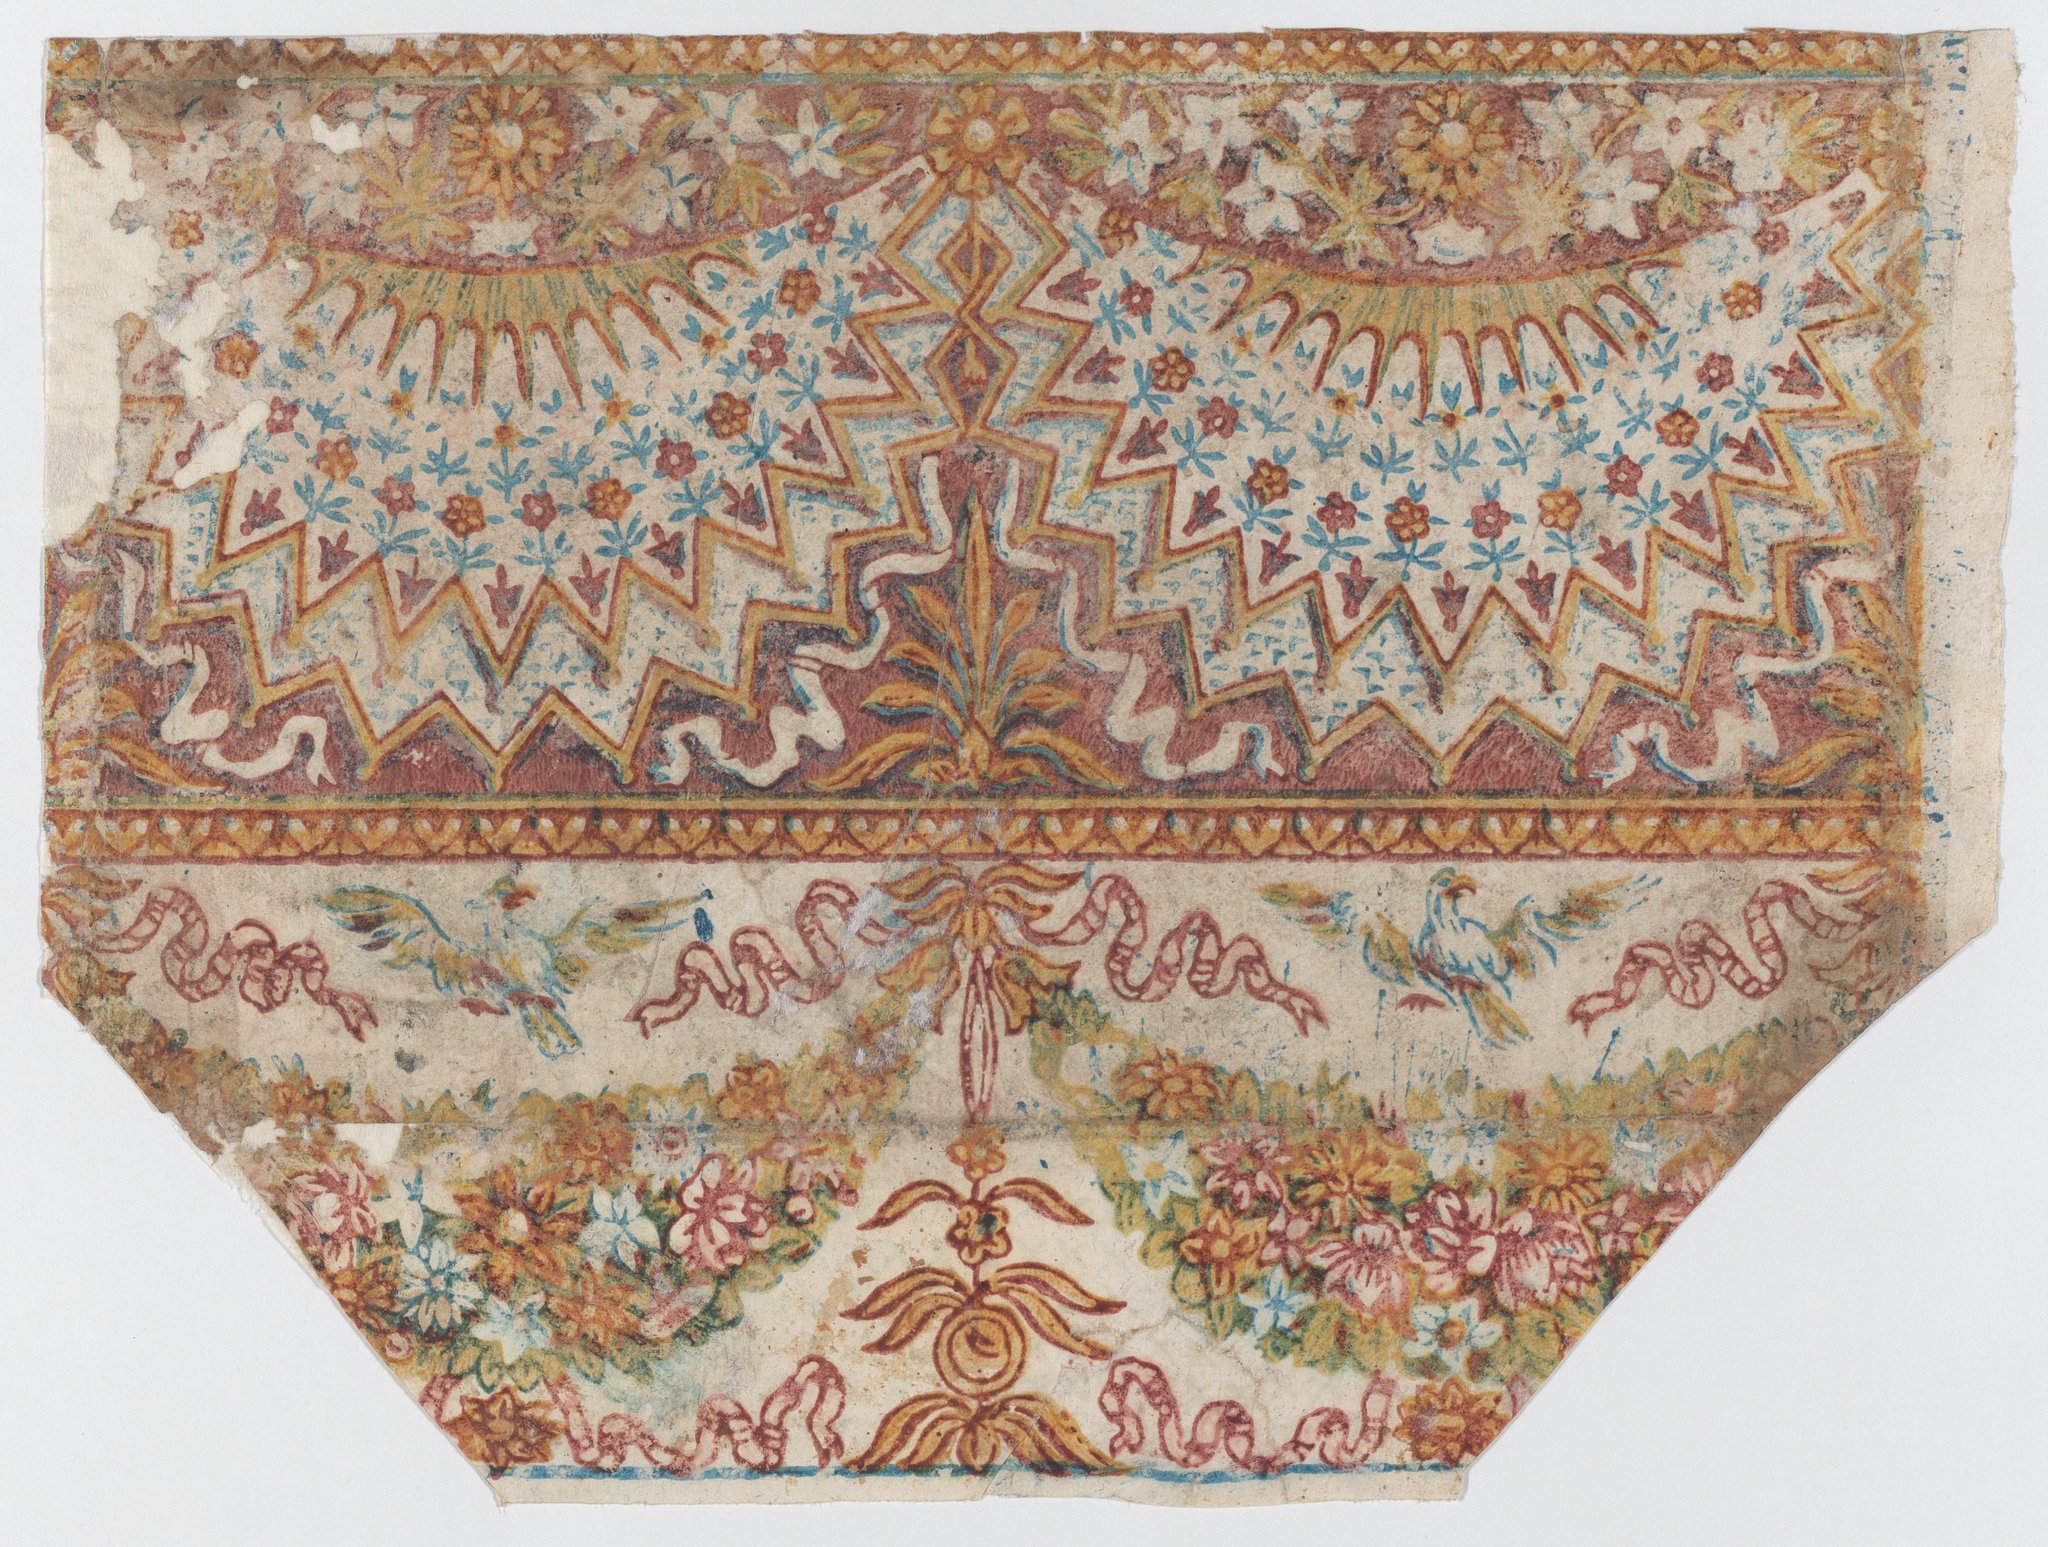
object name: print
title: Sheet with hanging draperies, festoons, and birds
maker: Anonymous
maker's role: artist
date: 1767-1866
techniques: relief print